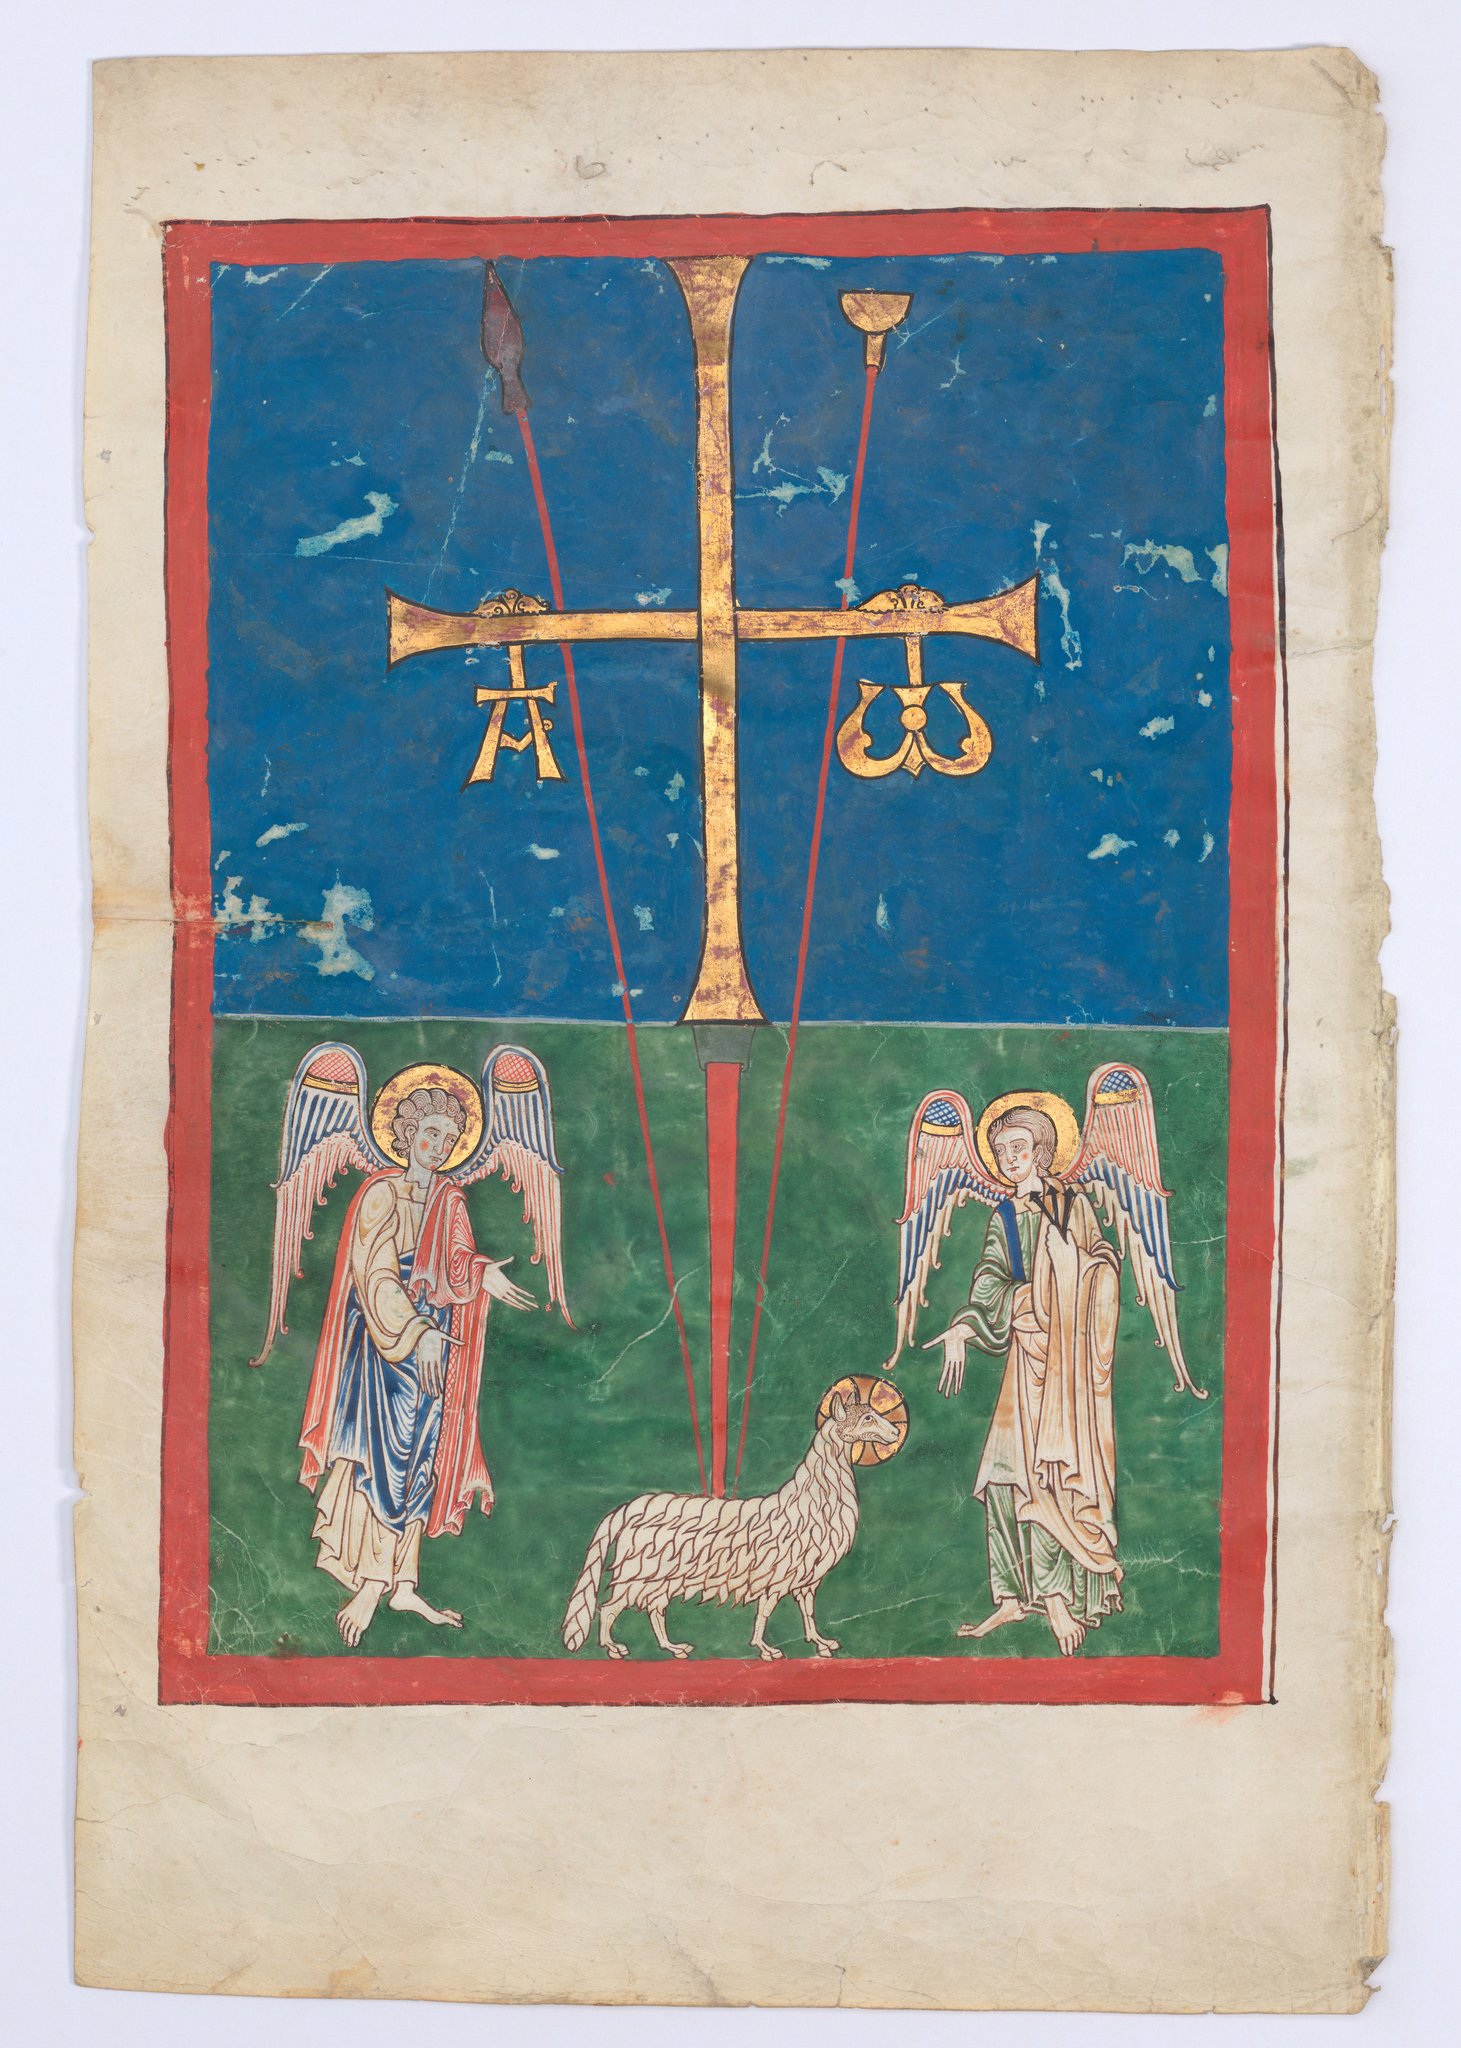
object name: beatus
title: Leaf from a Beatus Manuscript: the Lamb at the Foot of the Cross, Flanked by Two Angels; The Calling of Saint John with the Enthroned Christ flanked by Angels and a Man Holding a Book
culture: spanish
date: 1180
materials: gold, ink, parchment, paint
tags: lambs,angels,cross